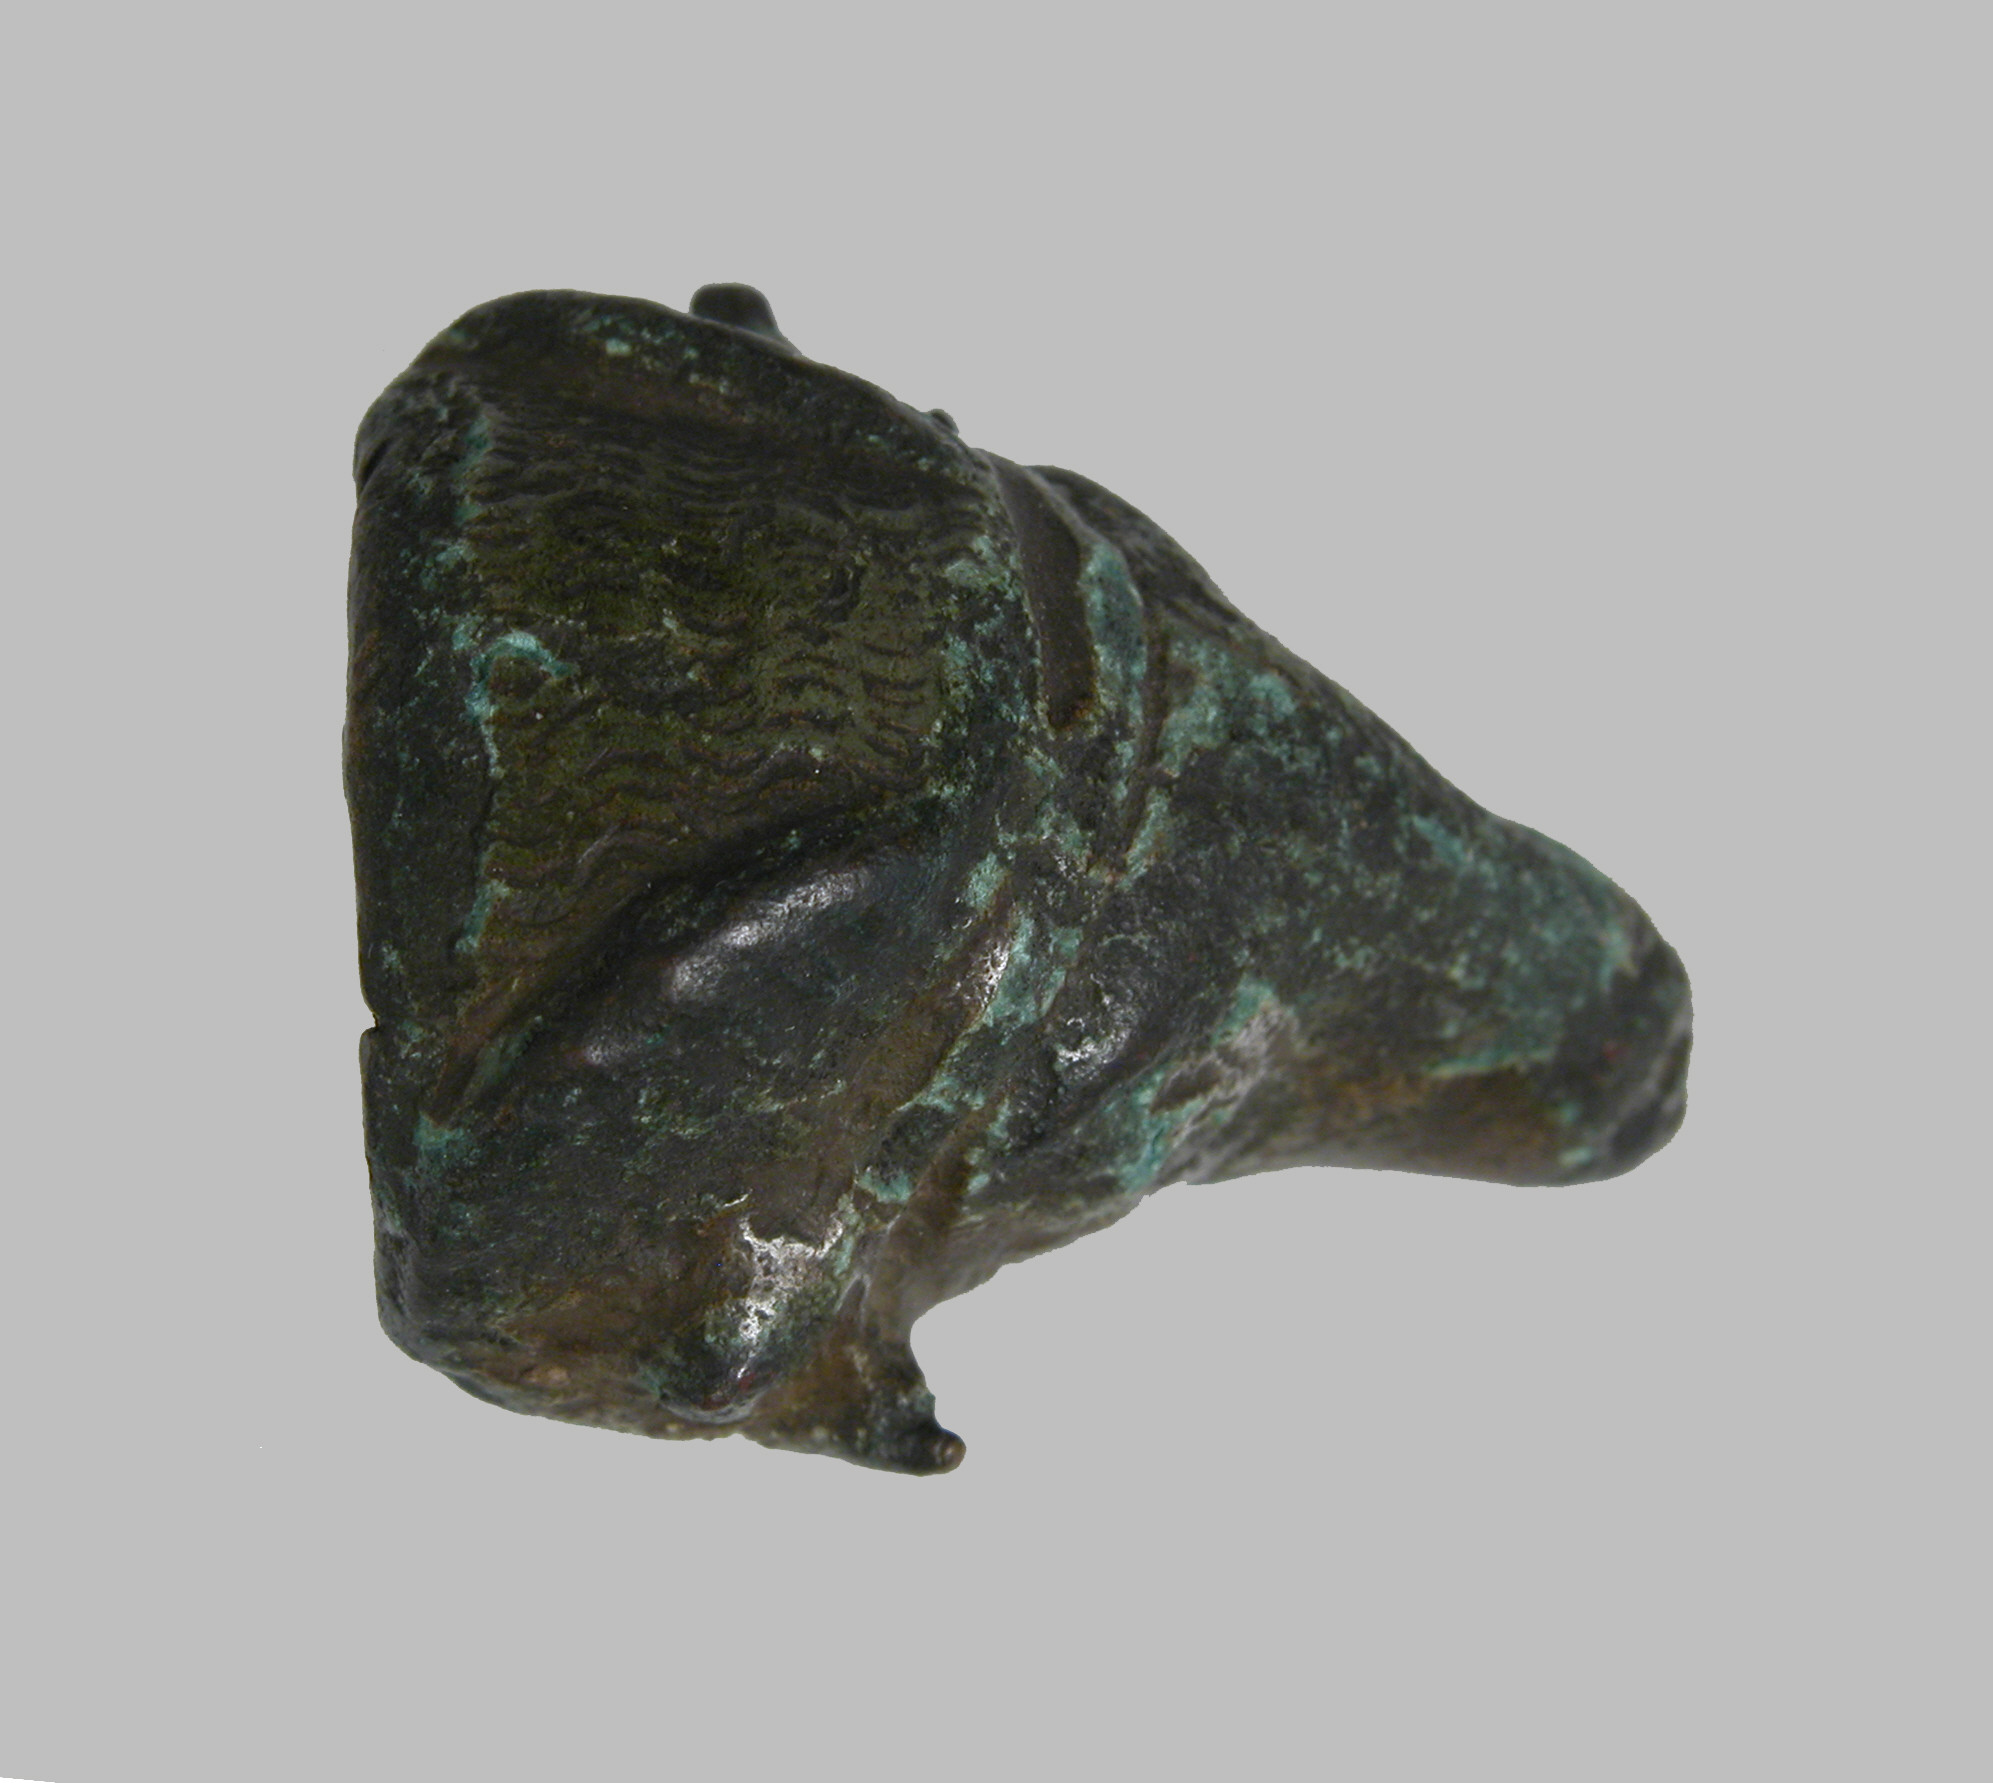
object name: key handle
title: Top of Key Handle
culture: roman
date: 1-700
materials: copper alloy